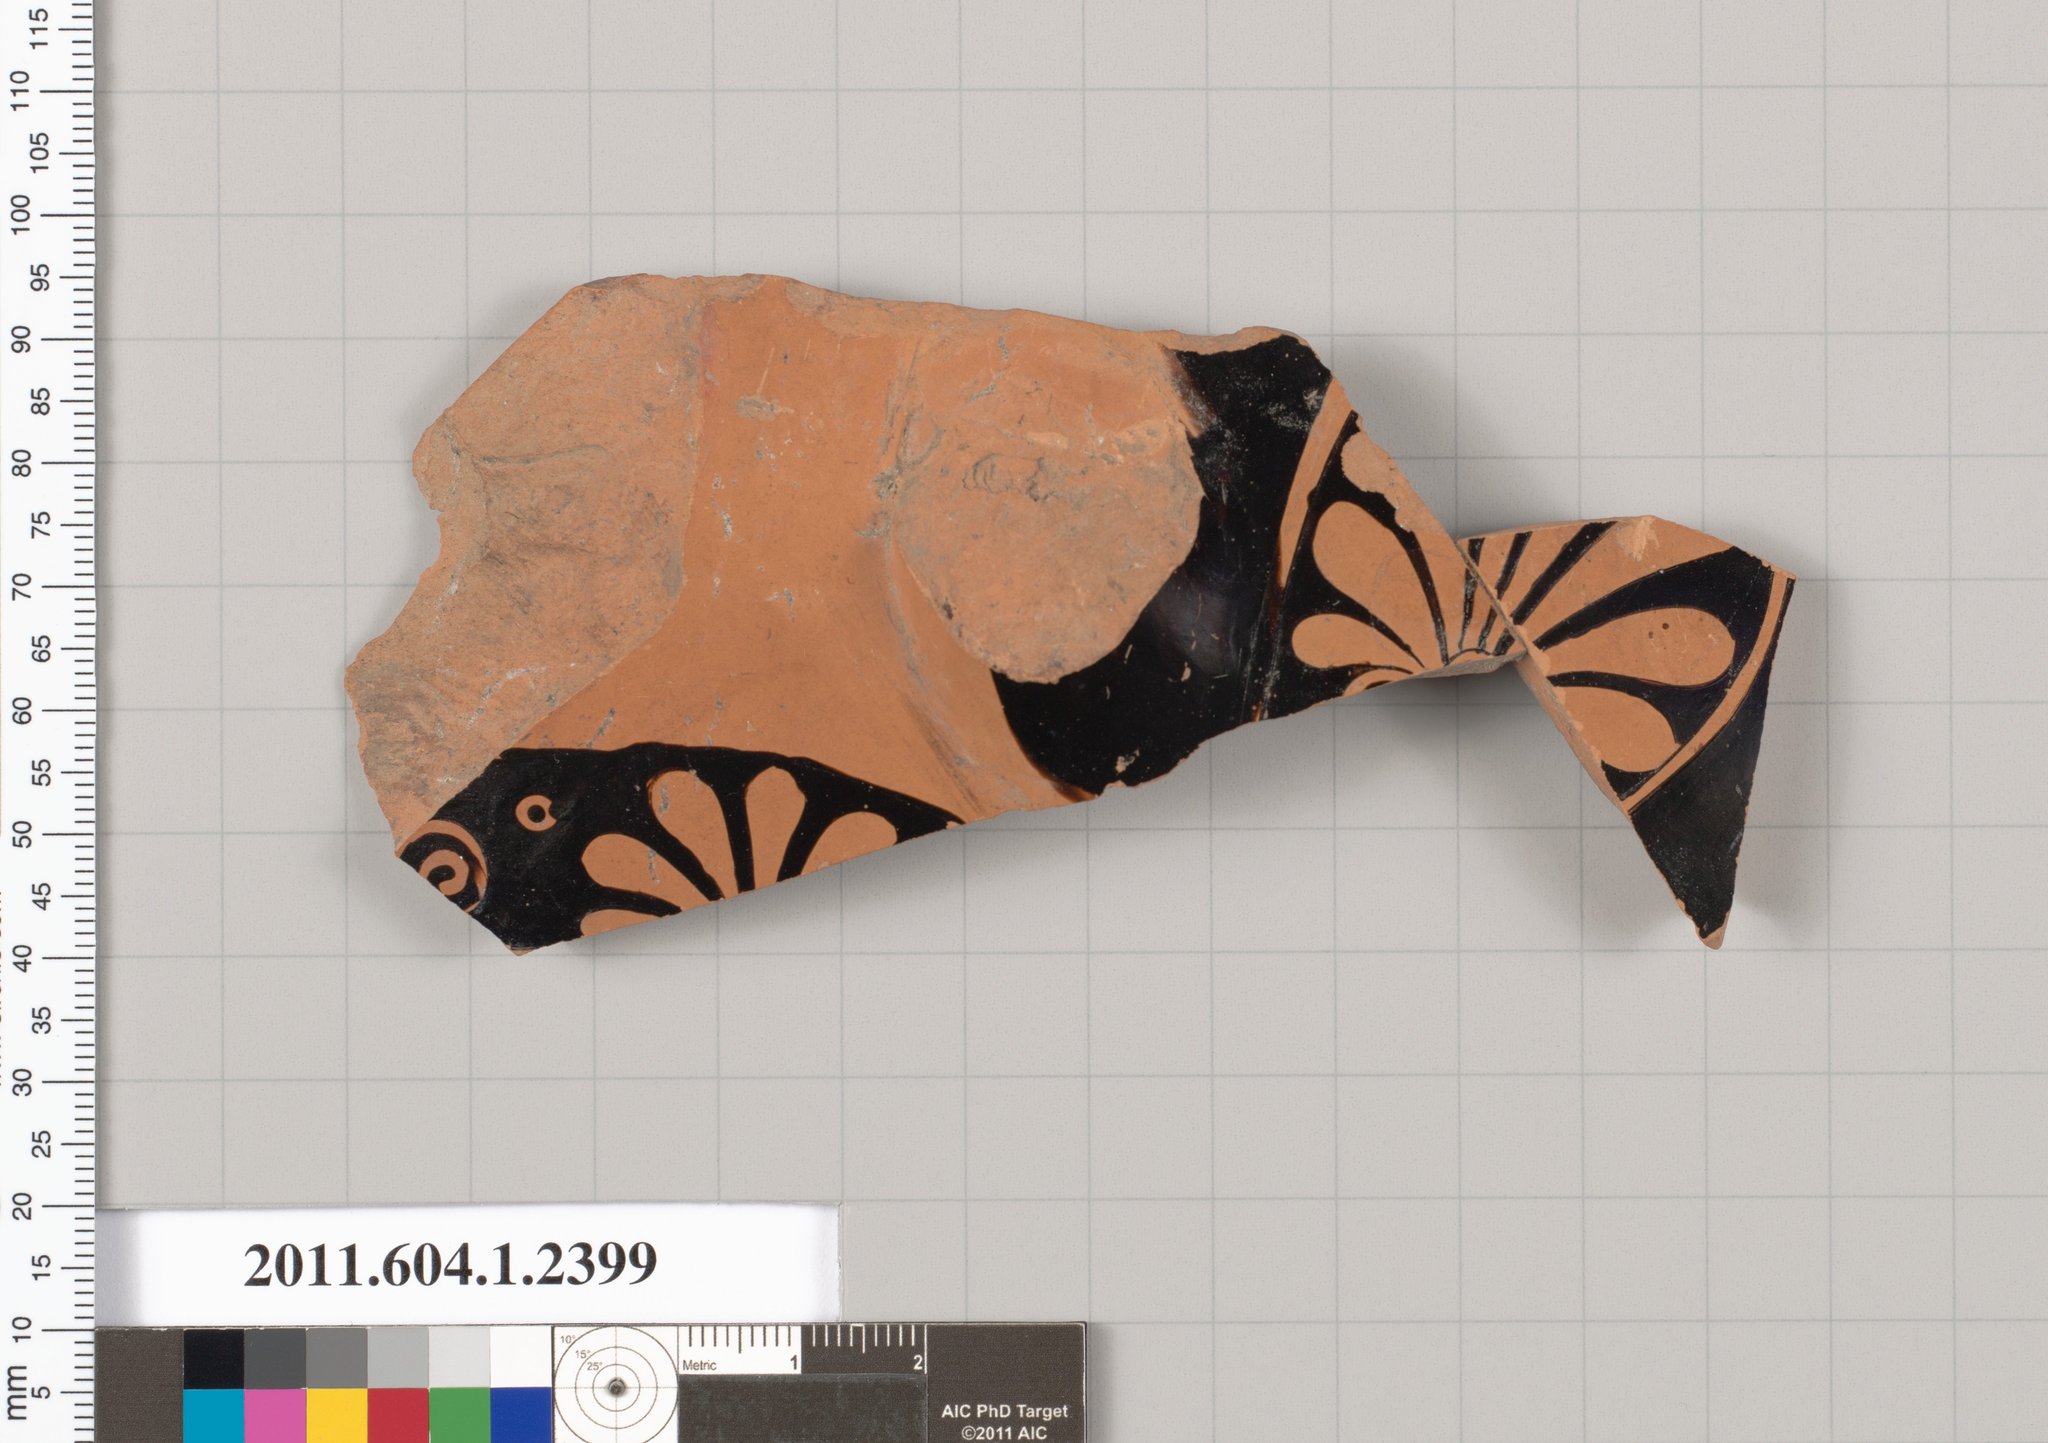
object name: kylix fragment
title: Terracotta fragment of a kylix (drinking cup)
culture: greek, attic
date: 534-468 BCE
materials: terracotta